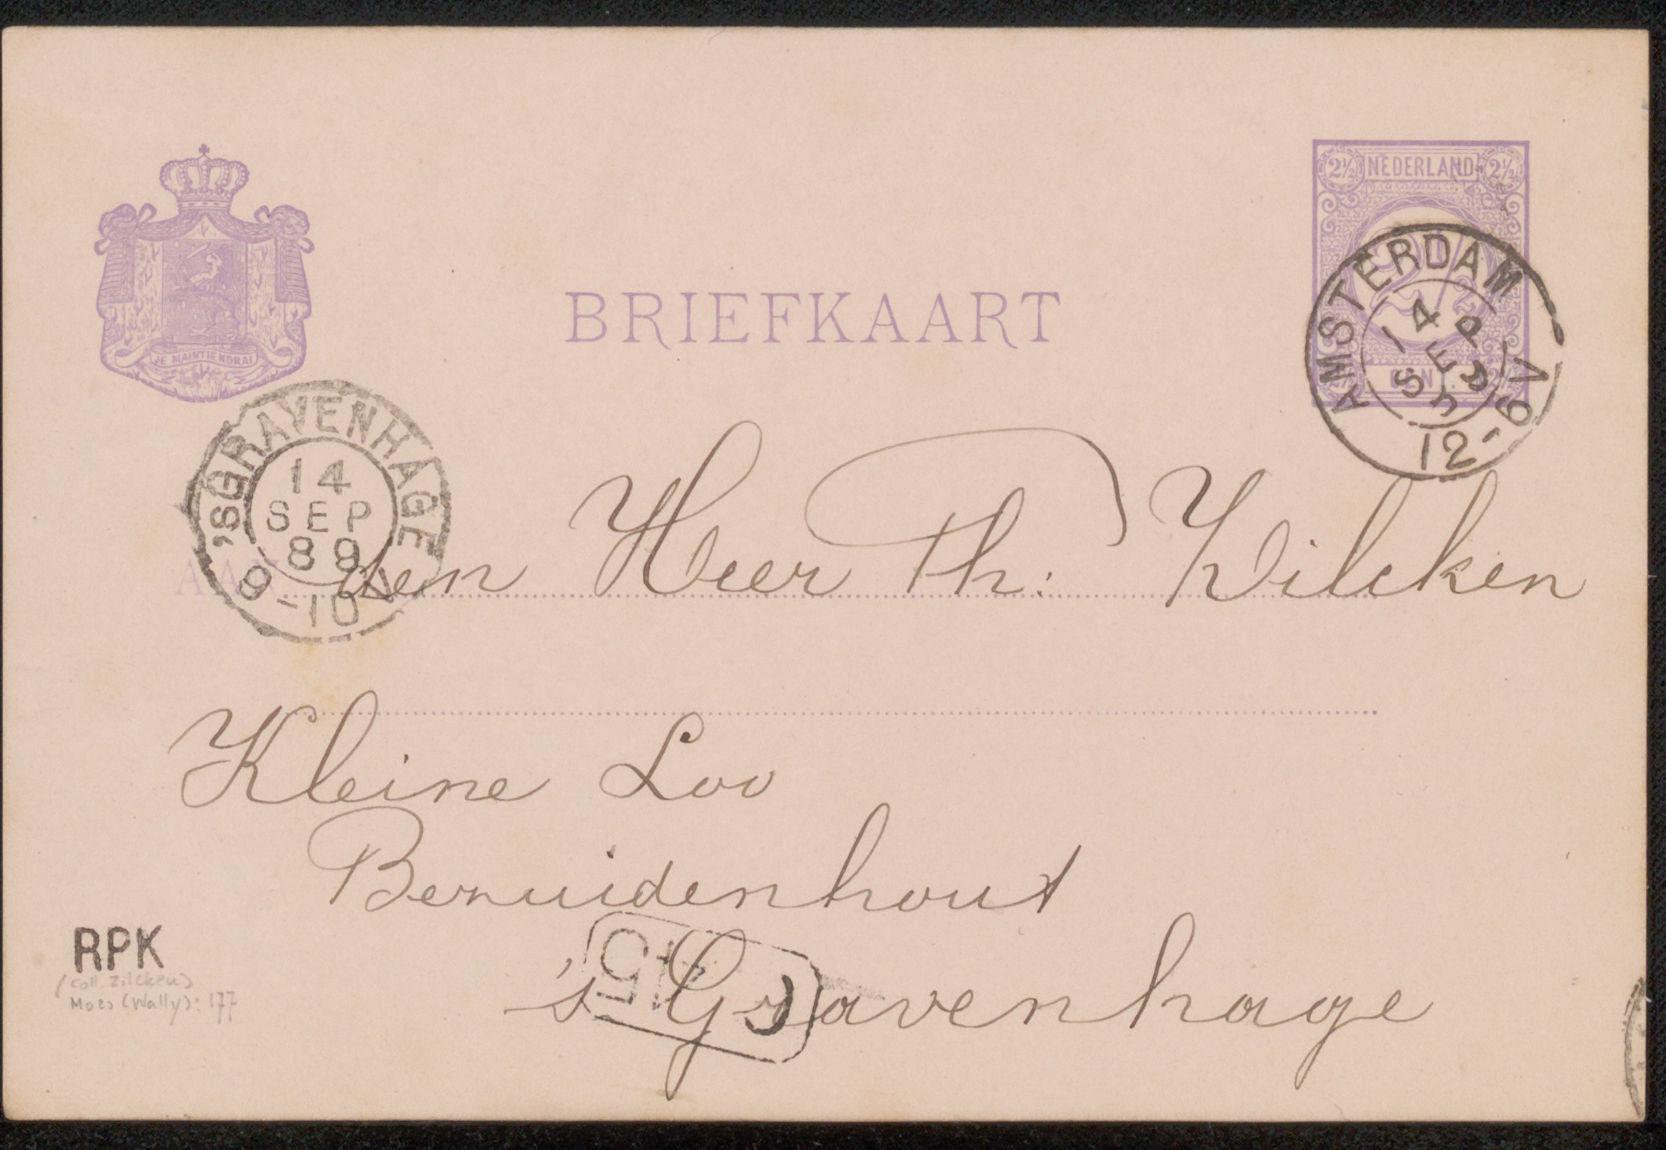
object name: postcard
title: Briefkaart aan Philip Zilcken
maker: wally moes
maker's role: draughtsman, print maker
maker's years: 1856-1918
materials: cardboard, ink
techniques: pen, writing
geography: amsterdam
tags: painter, draughtsman, philip zilcken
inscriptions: collector's mark: ‘RPK’